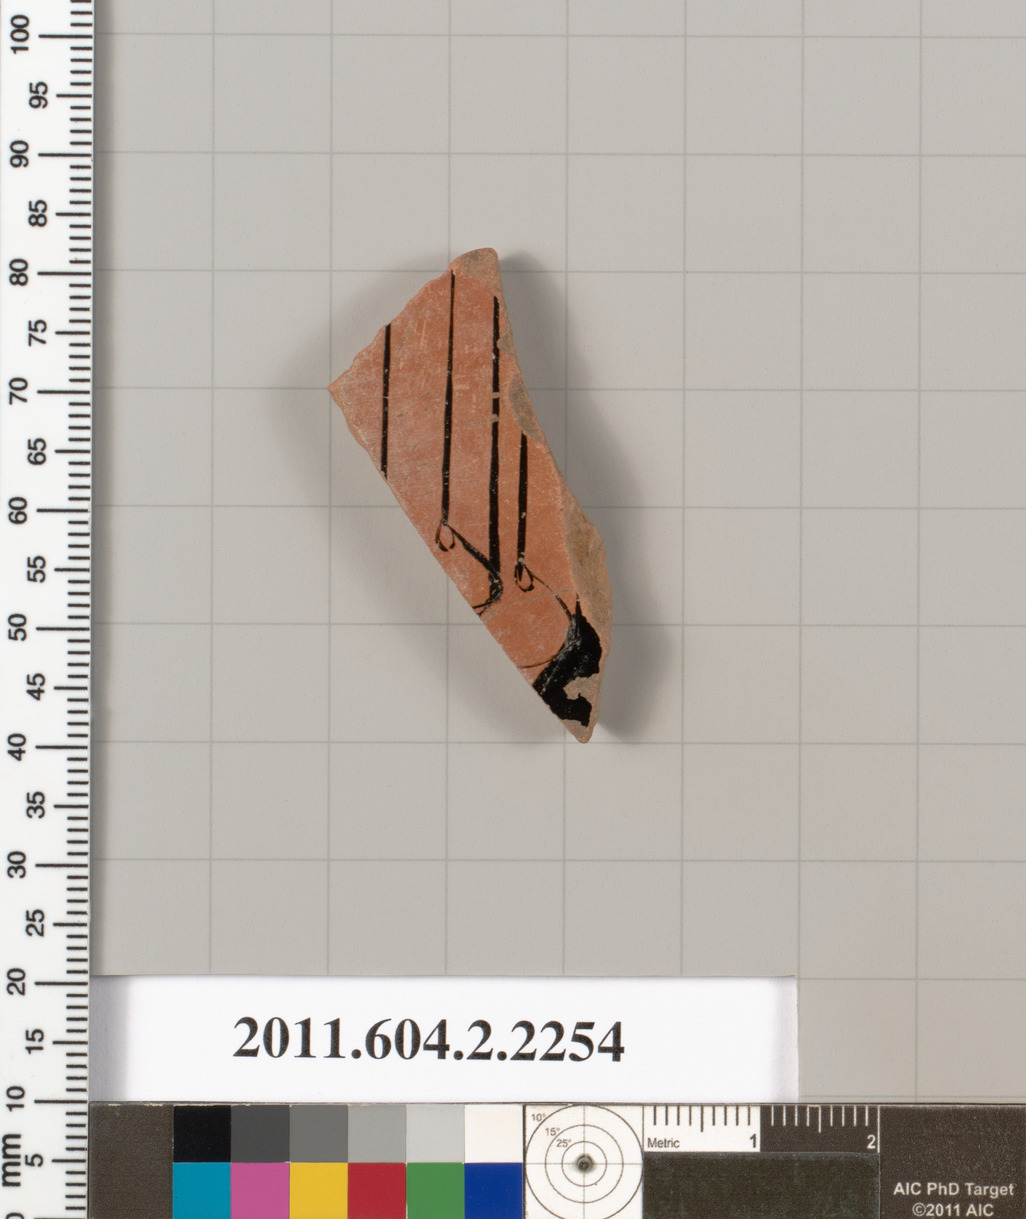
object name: pot fragment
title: Terracotta fragment of a pot; unglazed on the inside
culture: greek, attic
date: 500-480 BCE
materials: terracotta